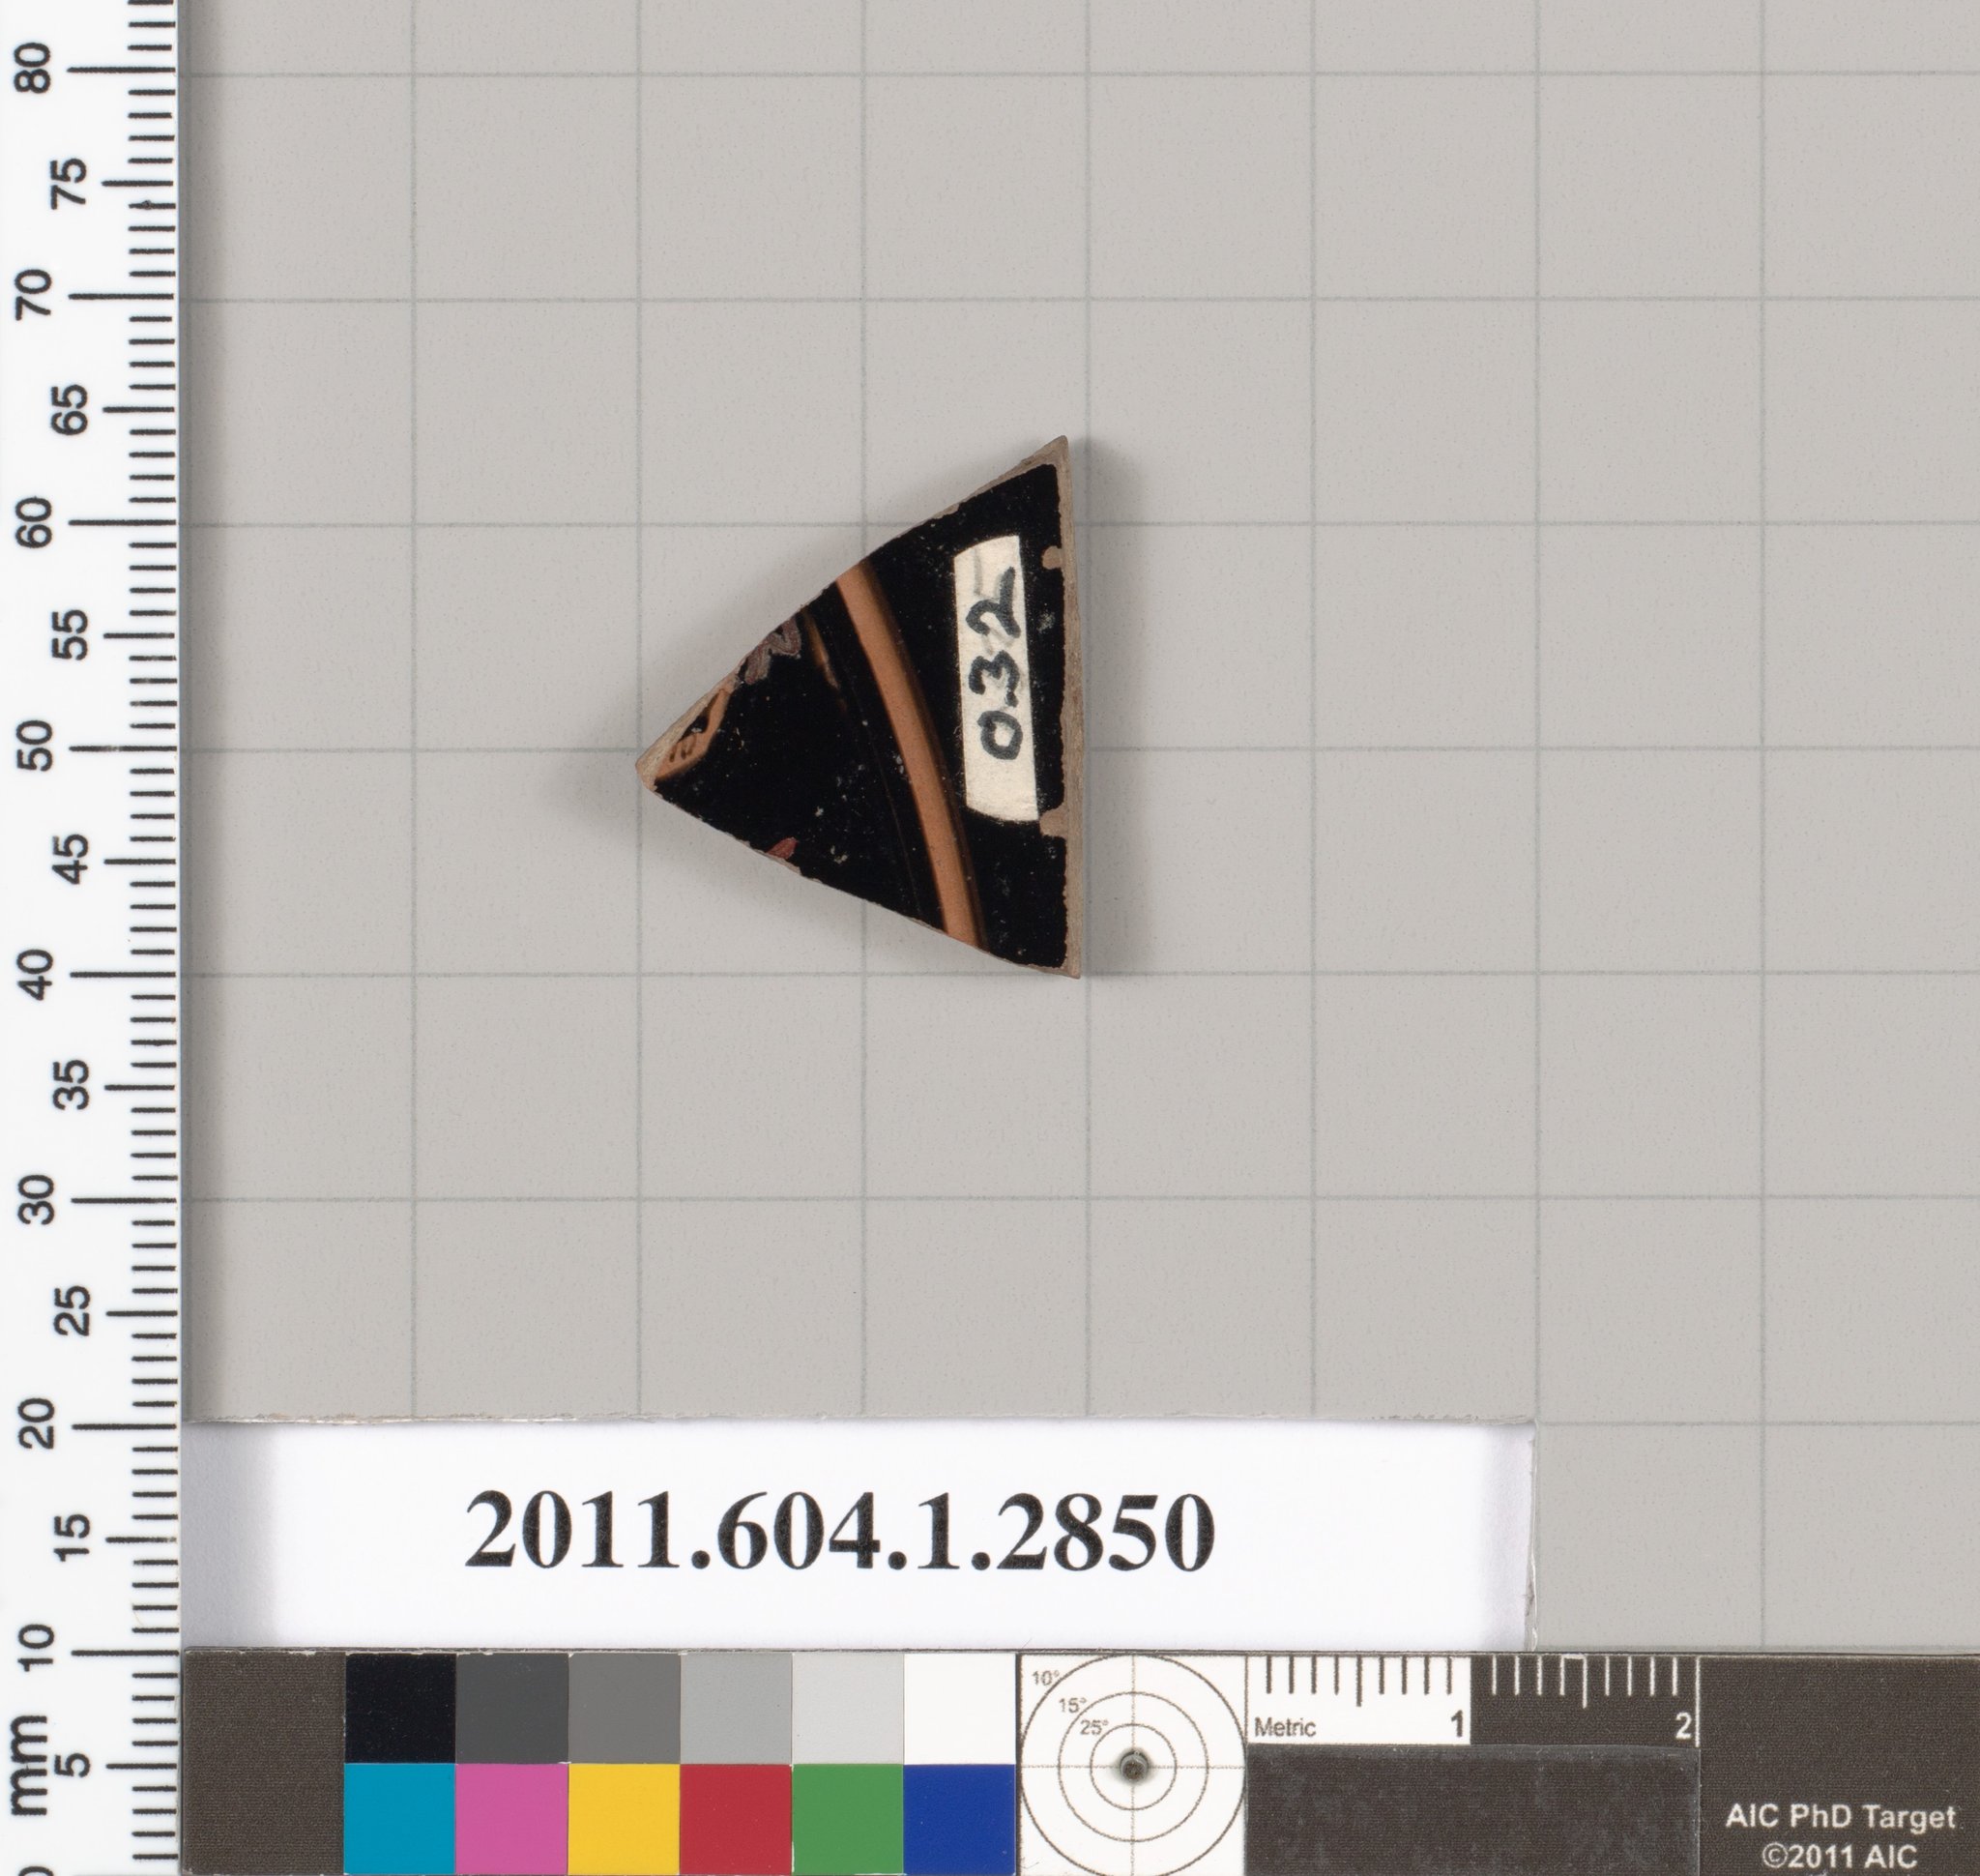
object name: kylix fragment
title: Terracotta fragment of a kylix (drinking cup)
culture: greek, attic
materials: terracotta